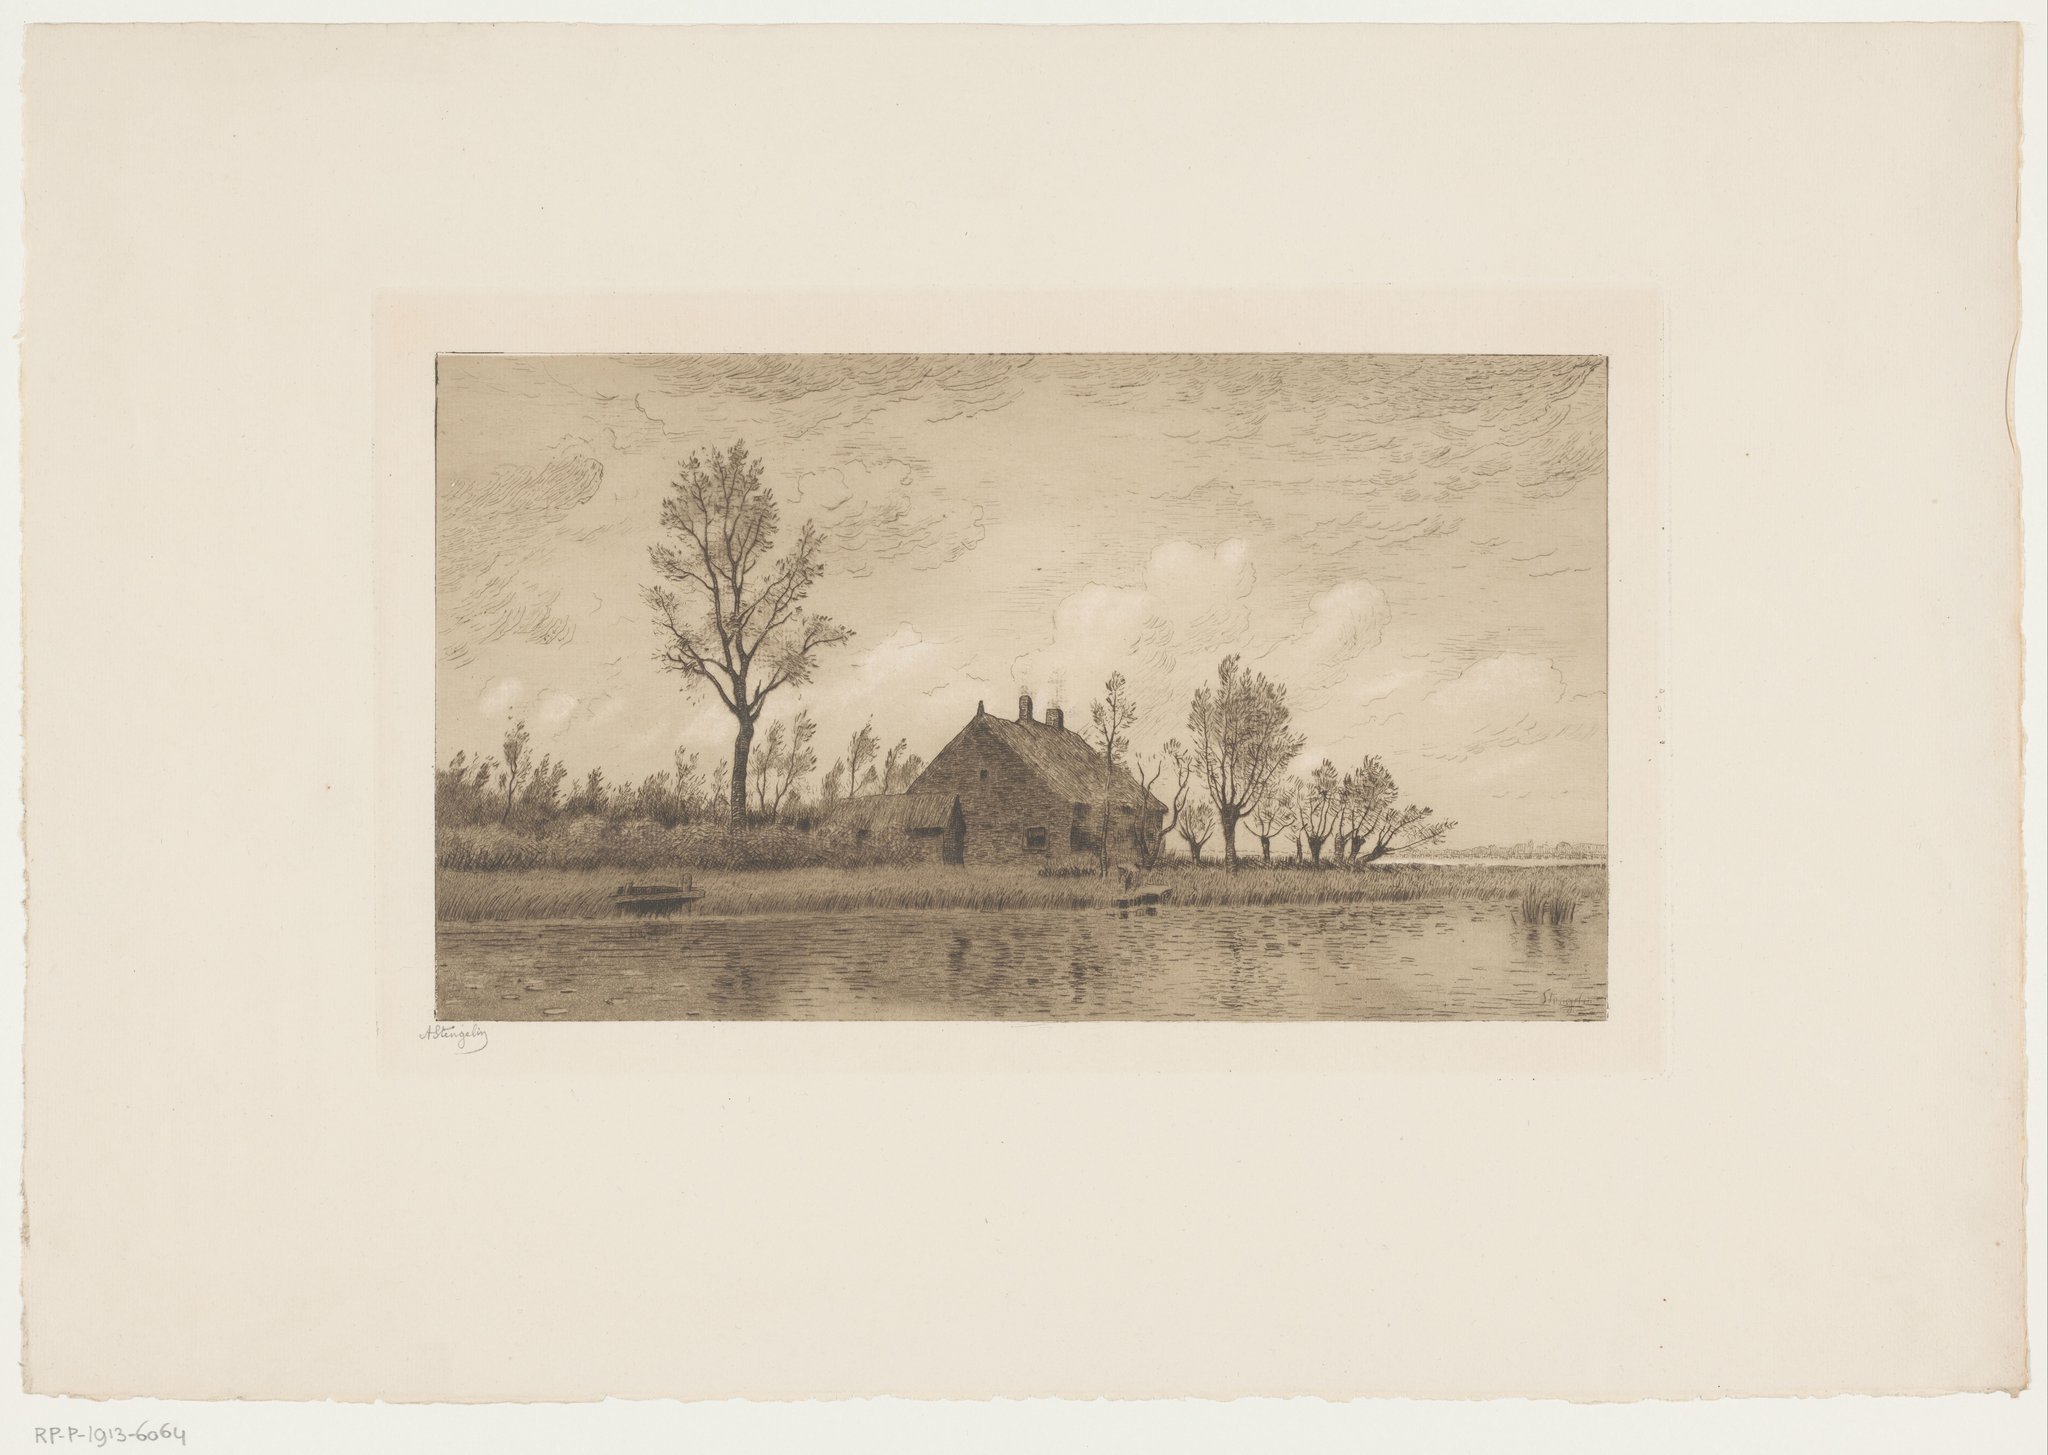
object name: print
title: Landschap met huis aan de oever van het Kagermeer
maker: alphonse stengelin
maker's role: painter, print maker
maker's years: 1852-1938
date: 1862-1913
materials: paper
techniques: aquatint, etching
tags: landscapes with waters, waterscapes, seascapes (in the temperate zone)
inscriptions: collector's mark: Lugt 2233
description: Zicht vanaf het meer op een huis met daarnaast knotwilgen.